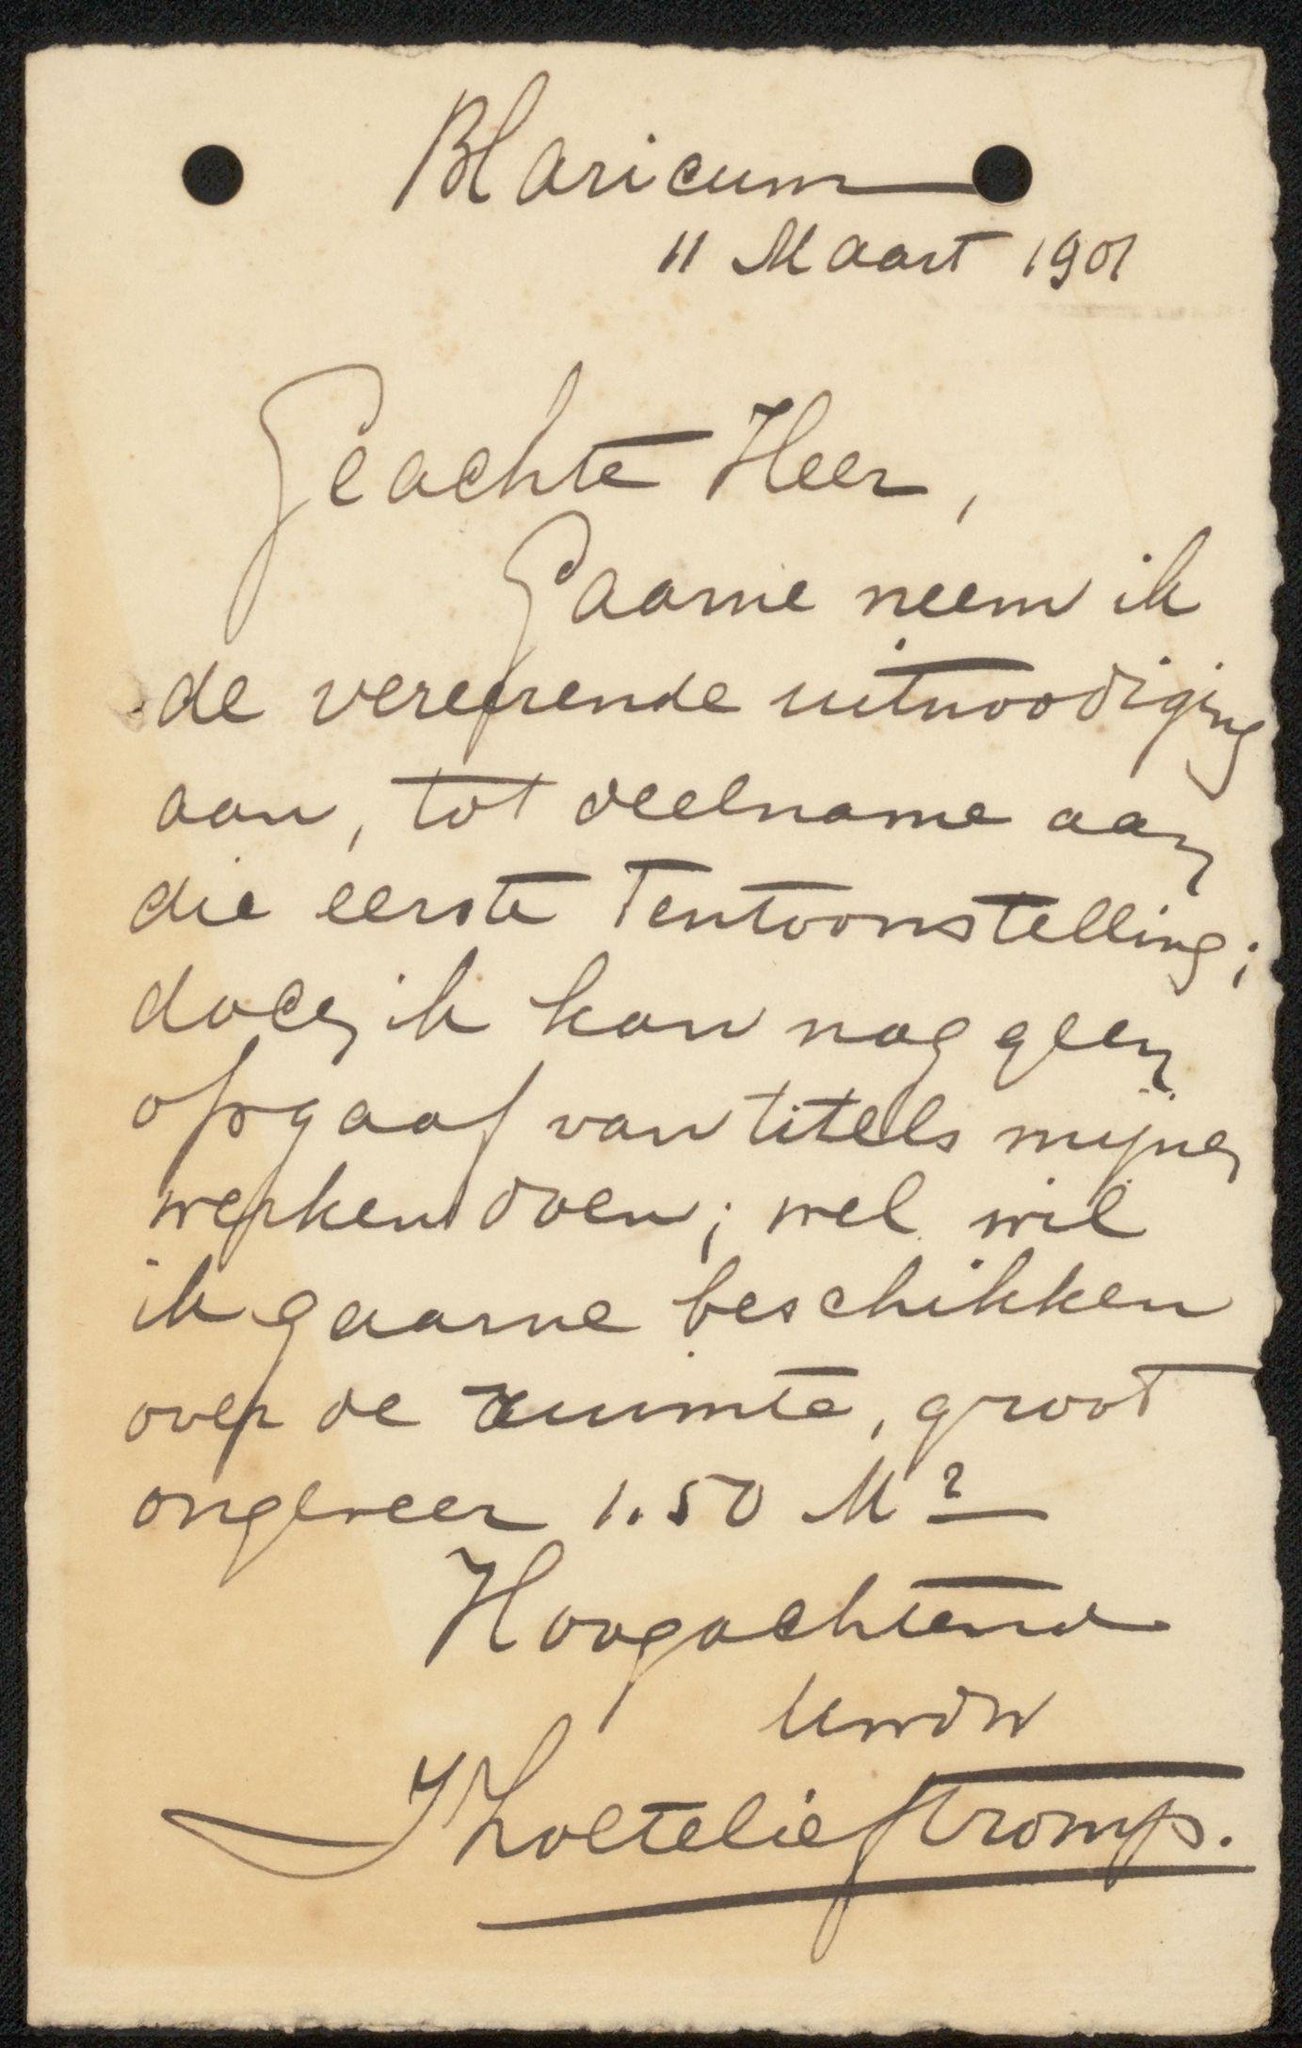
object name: letter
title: Brief aan Philip Zilcken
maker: jan zoetelief tromp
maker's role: draughtsman, painter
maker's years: 1872-1947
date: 1901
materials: ink, paper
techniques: pen, writing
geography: blaricum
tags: the hague, painter, draughtsman, philip zilcken, exhibition ~ art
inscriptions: watermark, collector's mark: ‘RPK’